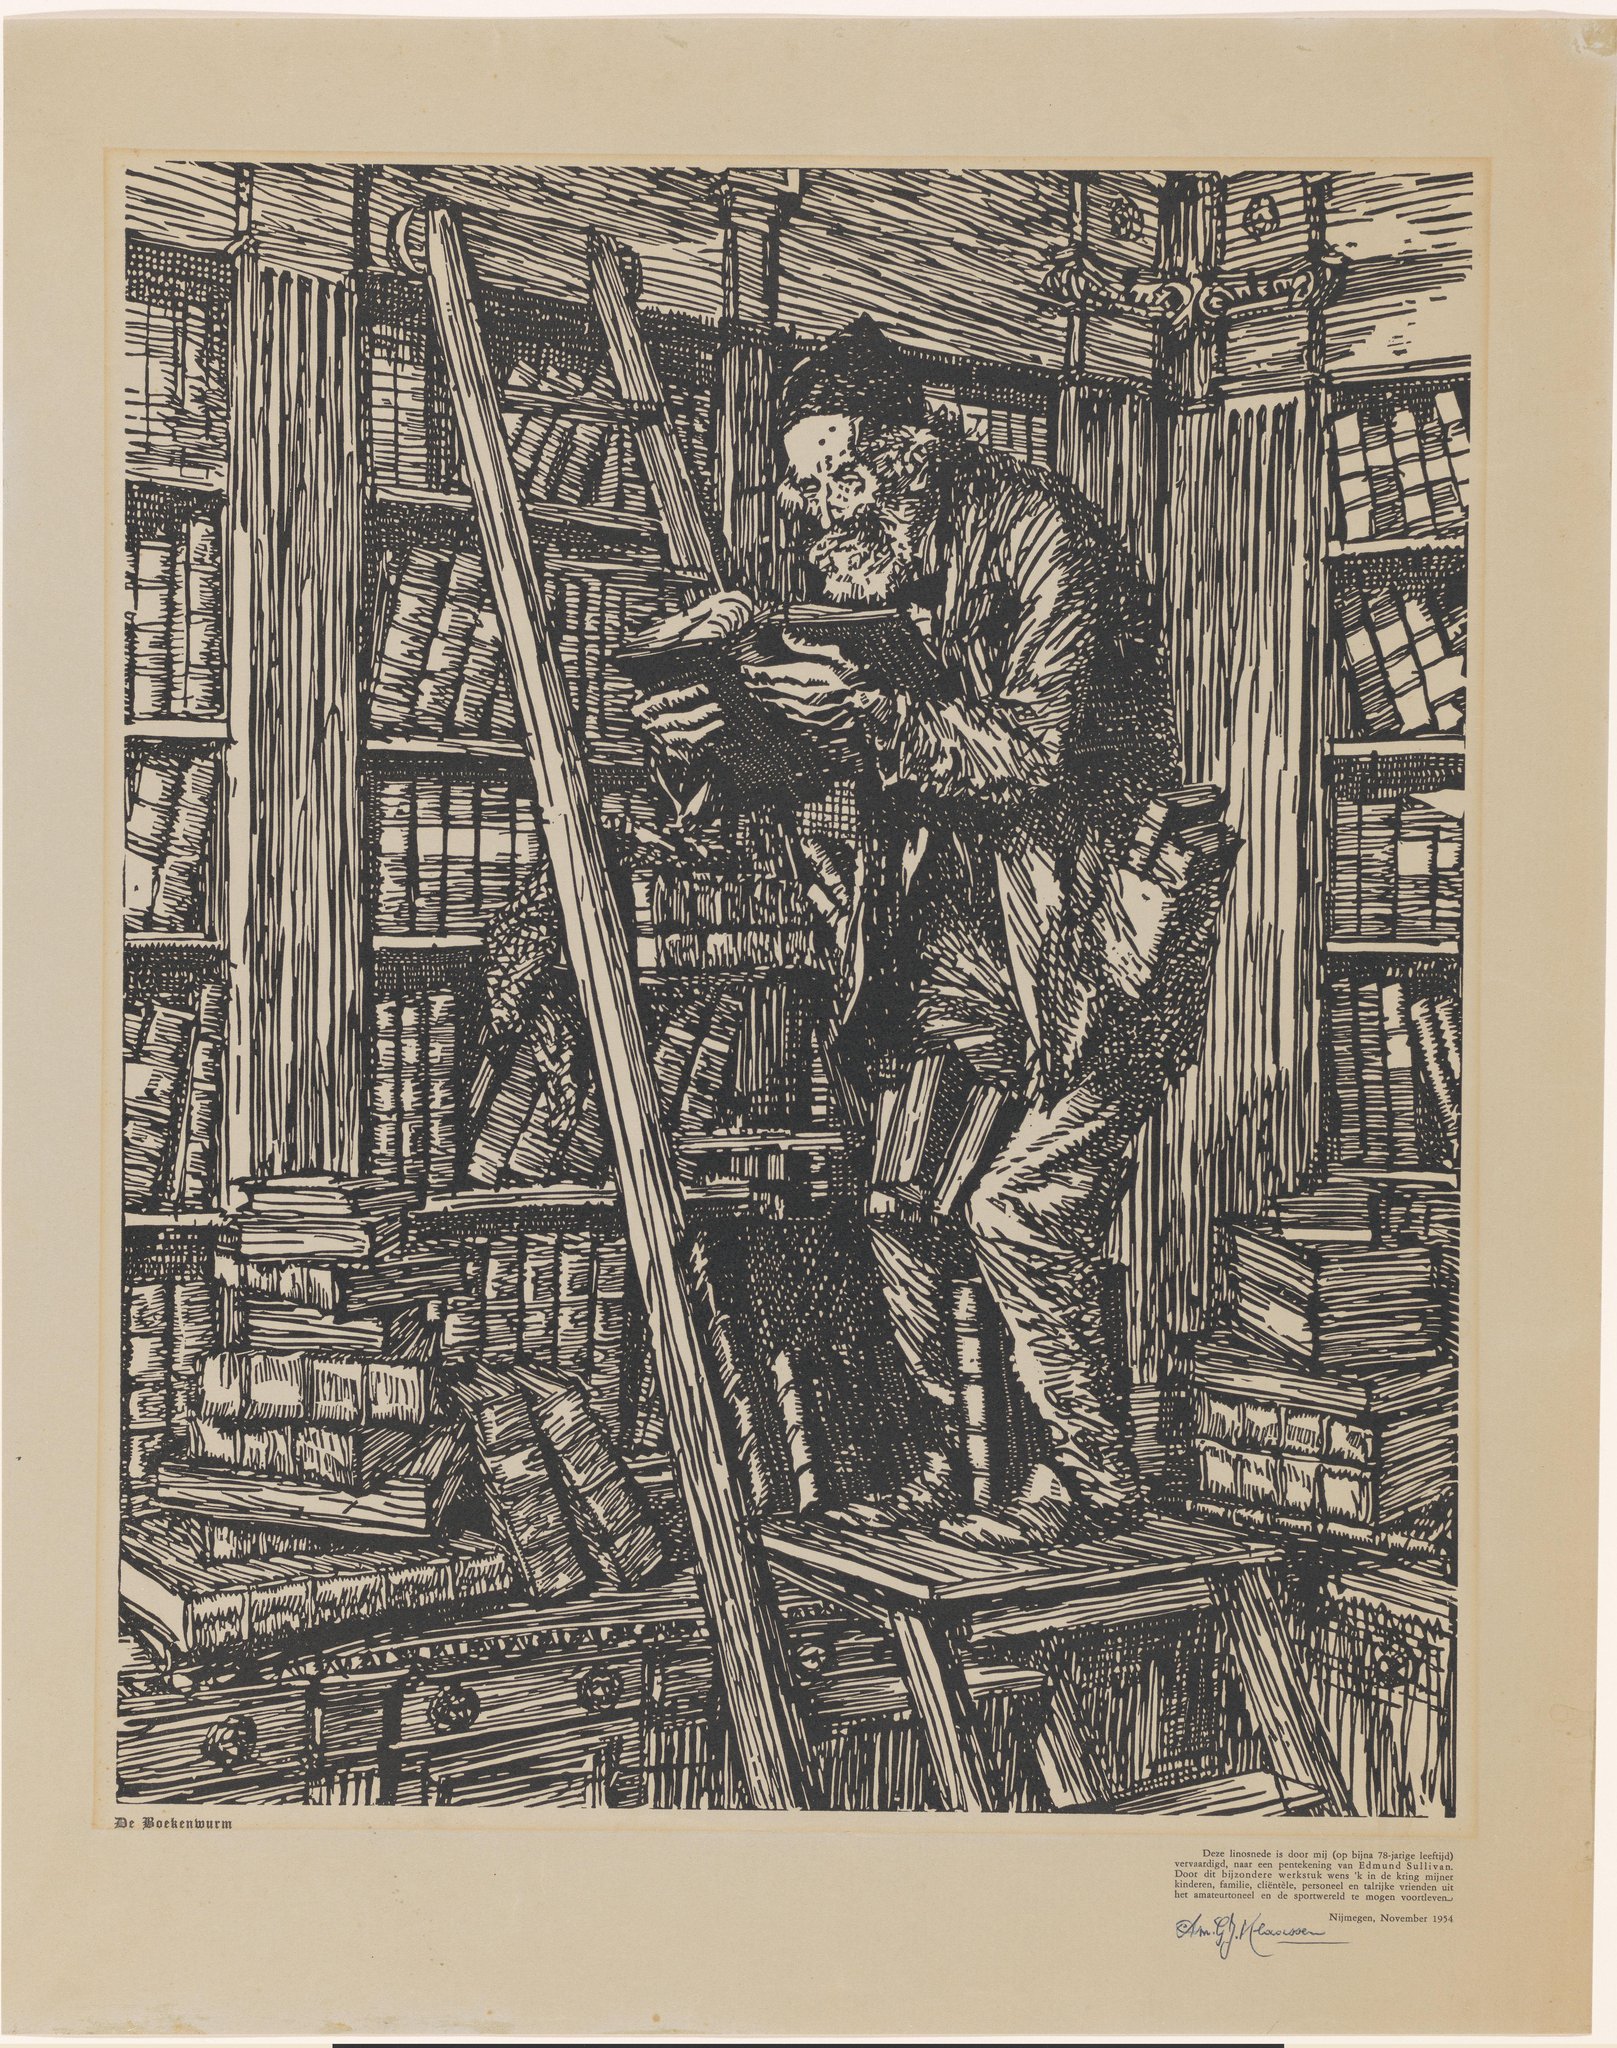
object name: print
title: Man in een bibliotheek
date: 1911-1954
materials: paper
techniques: linocut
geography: nijmegen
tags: bookshelves, study; 'studiolo'; library, book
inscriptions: collector's mark: Lugt 4780, collector's mark: Lugt 2228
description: In een bibliotheek staat een oude man met een baard met een boek in zijn handen op een bibliotheektrap. De zakken van zijn jas puilen uit van de boeken.